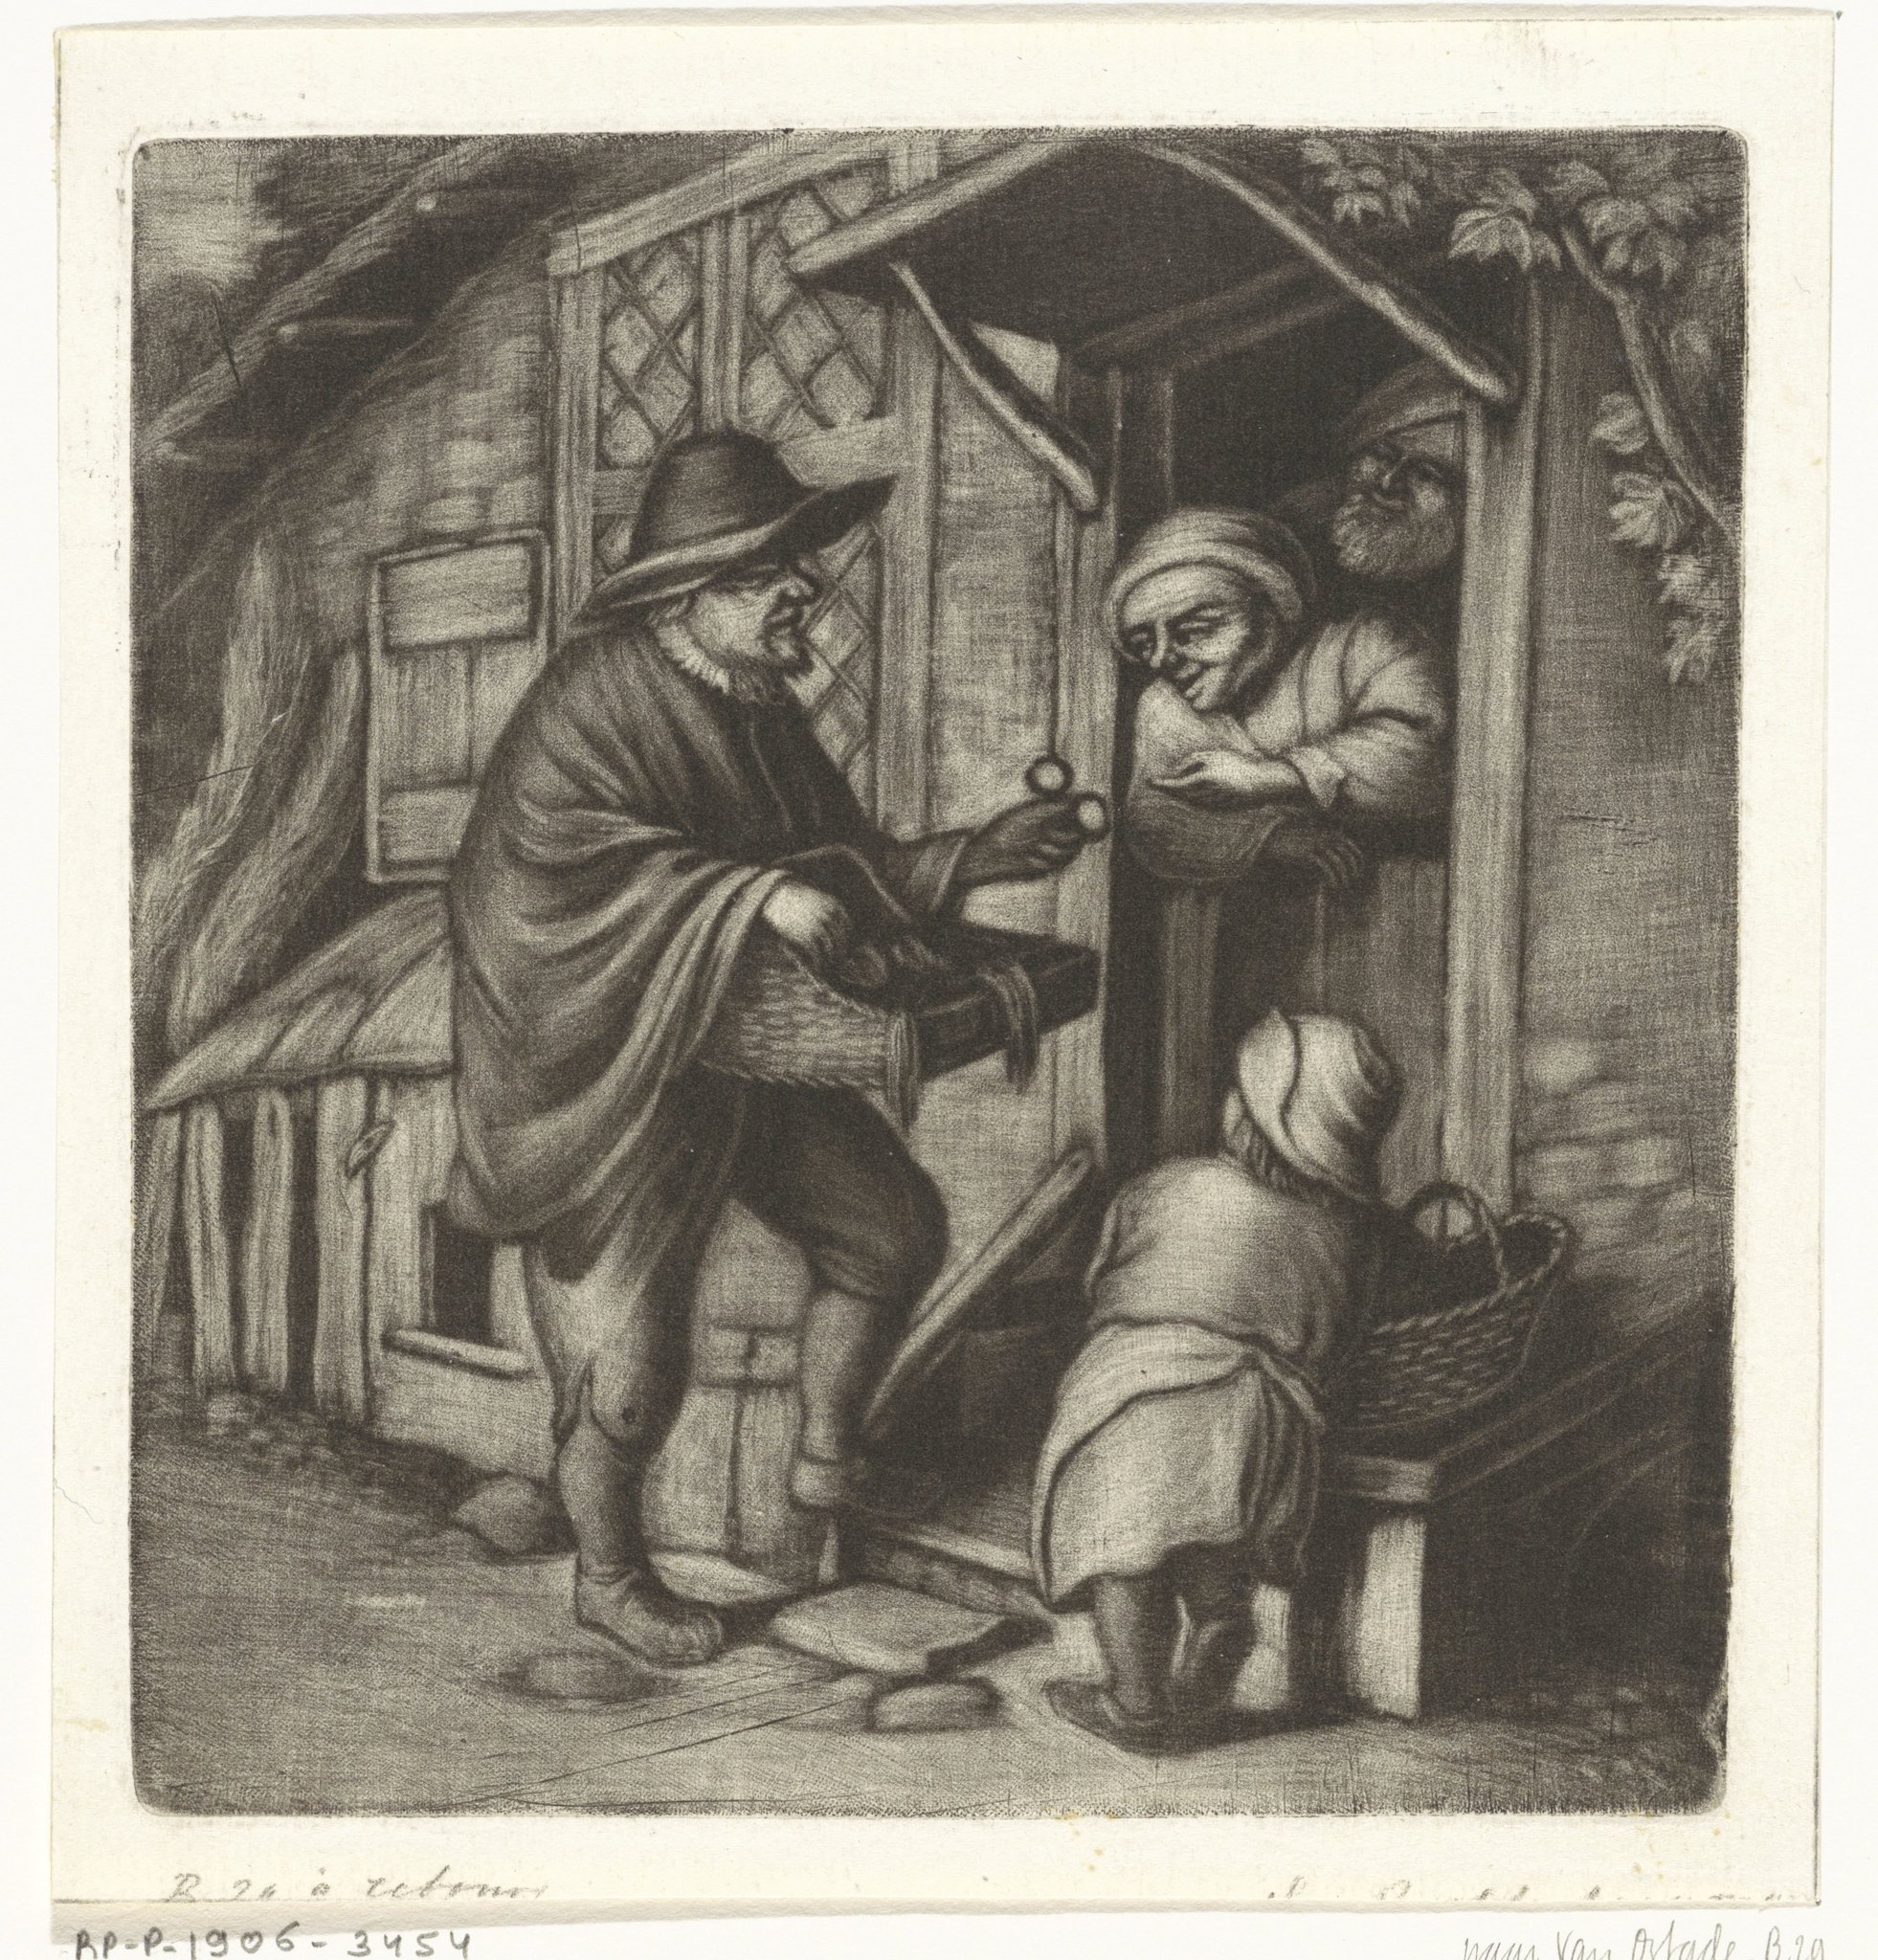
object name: print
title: Brillenverkoper en een oude vrouw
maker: jacob hoolaart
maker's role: print maker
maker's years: 1713-1789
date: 1723-1789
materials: paper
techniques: mezzotint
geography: dordrecht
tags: eyeglasses, spectacles, old woman, wandering or travelling merchant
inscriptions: collector's mark: Lugt 2228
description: Een brillenverkoper met een mand vol brillen staat voor het huis van een oude vrouw. Zij leunt op de onderdeur terwijl ze een bril krijgt aangereikt. Een kind kijkt toe.